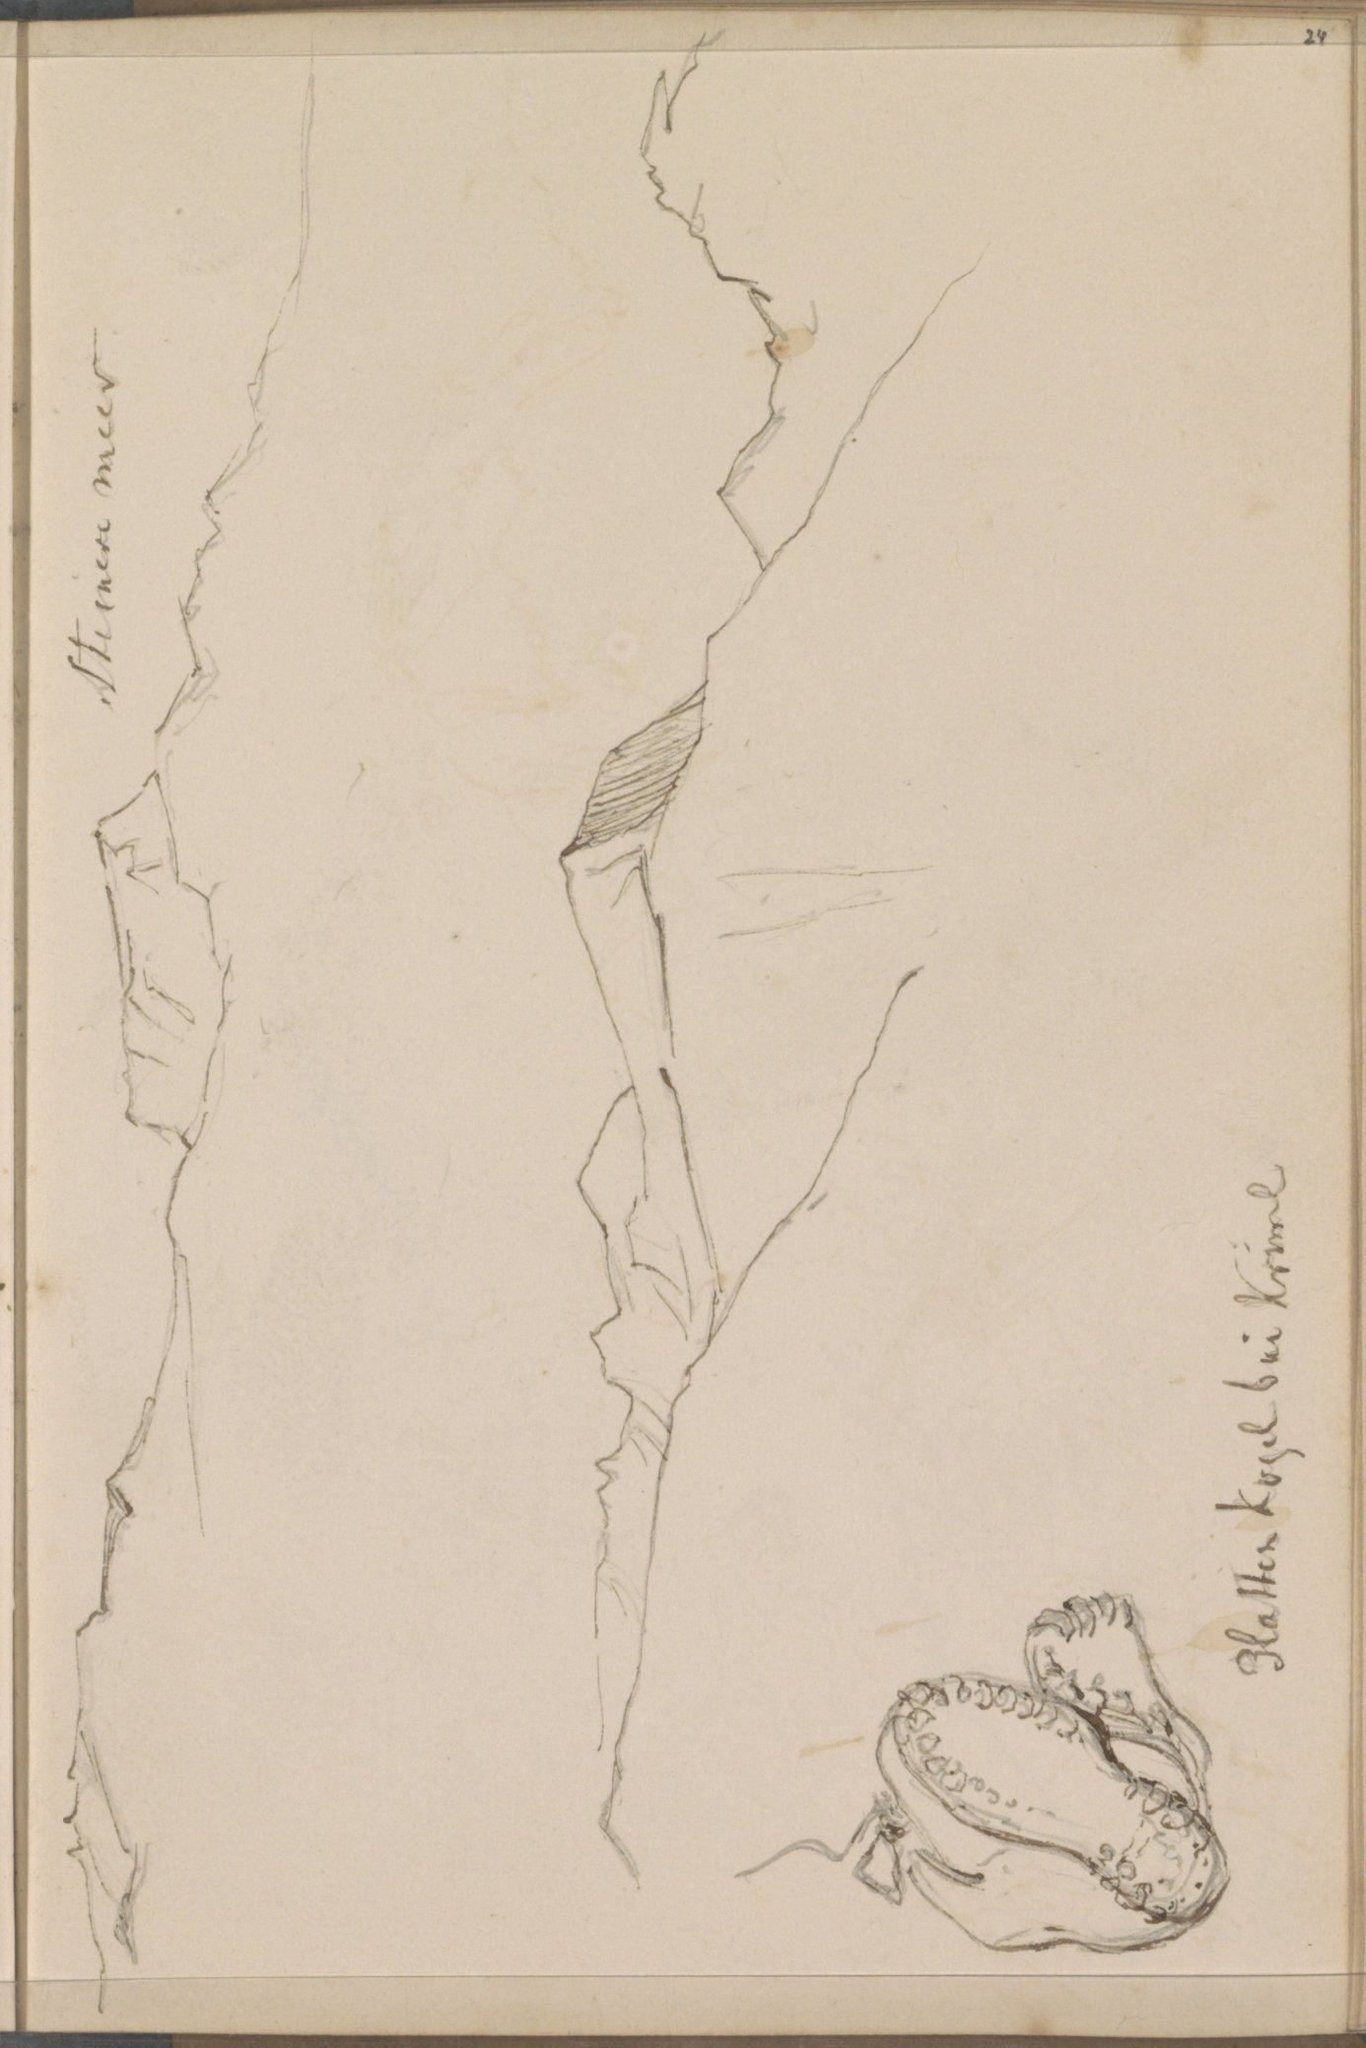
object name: sketchbook leaf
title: Steinernes Meer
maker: johannes tavenraat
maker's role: draughtsman, painter, print maker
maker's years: 1809-1881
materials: ink, paper, pencil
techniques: pen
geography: alps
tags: mountain-range, snow peaks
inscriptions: annotation: ‘Steinere meer/ Platten Kogel bei Kiml’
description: Blad 24 recto uit een schetsboek met 47 bladen.